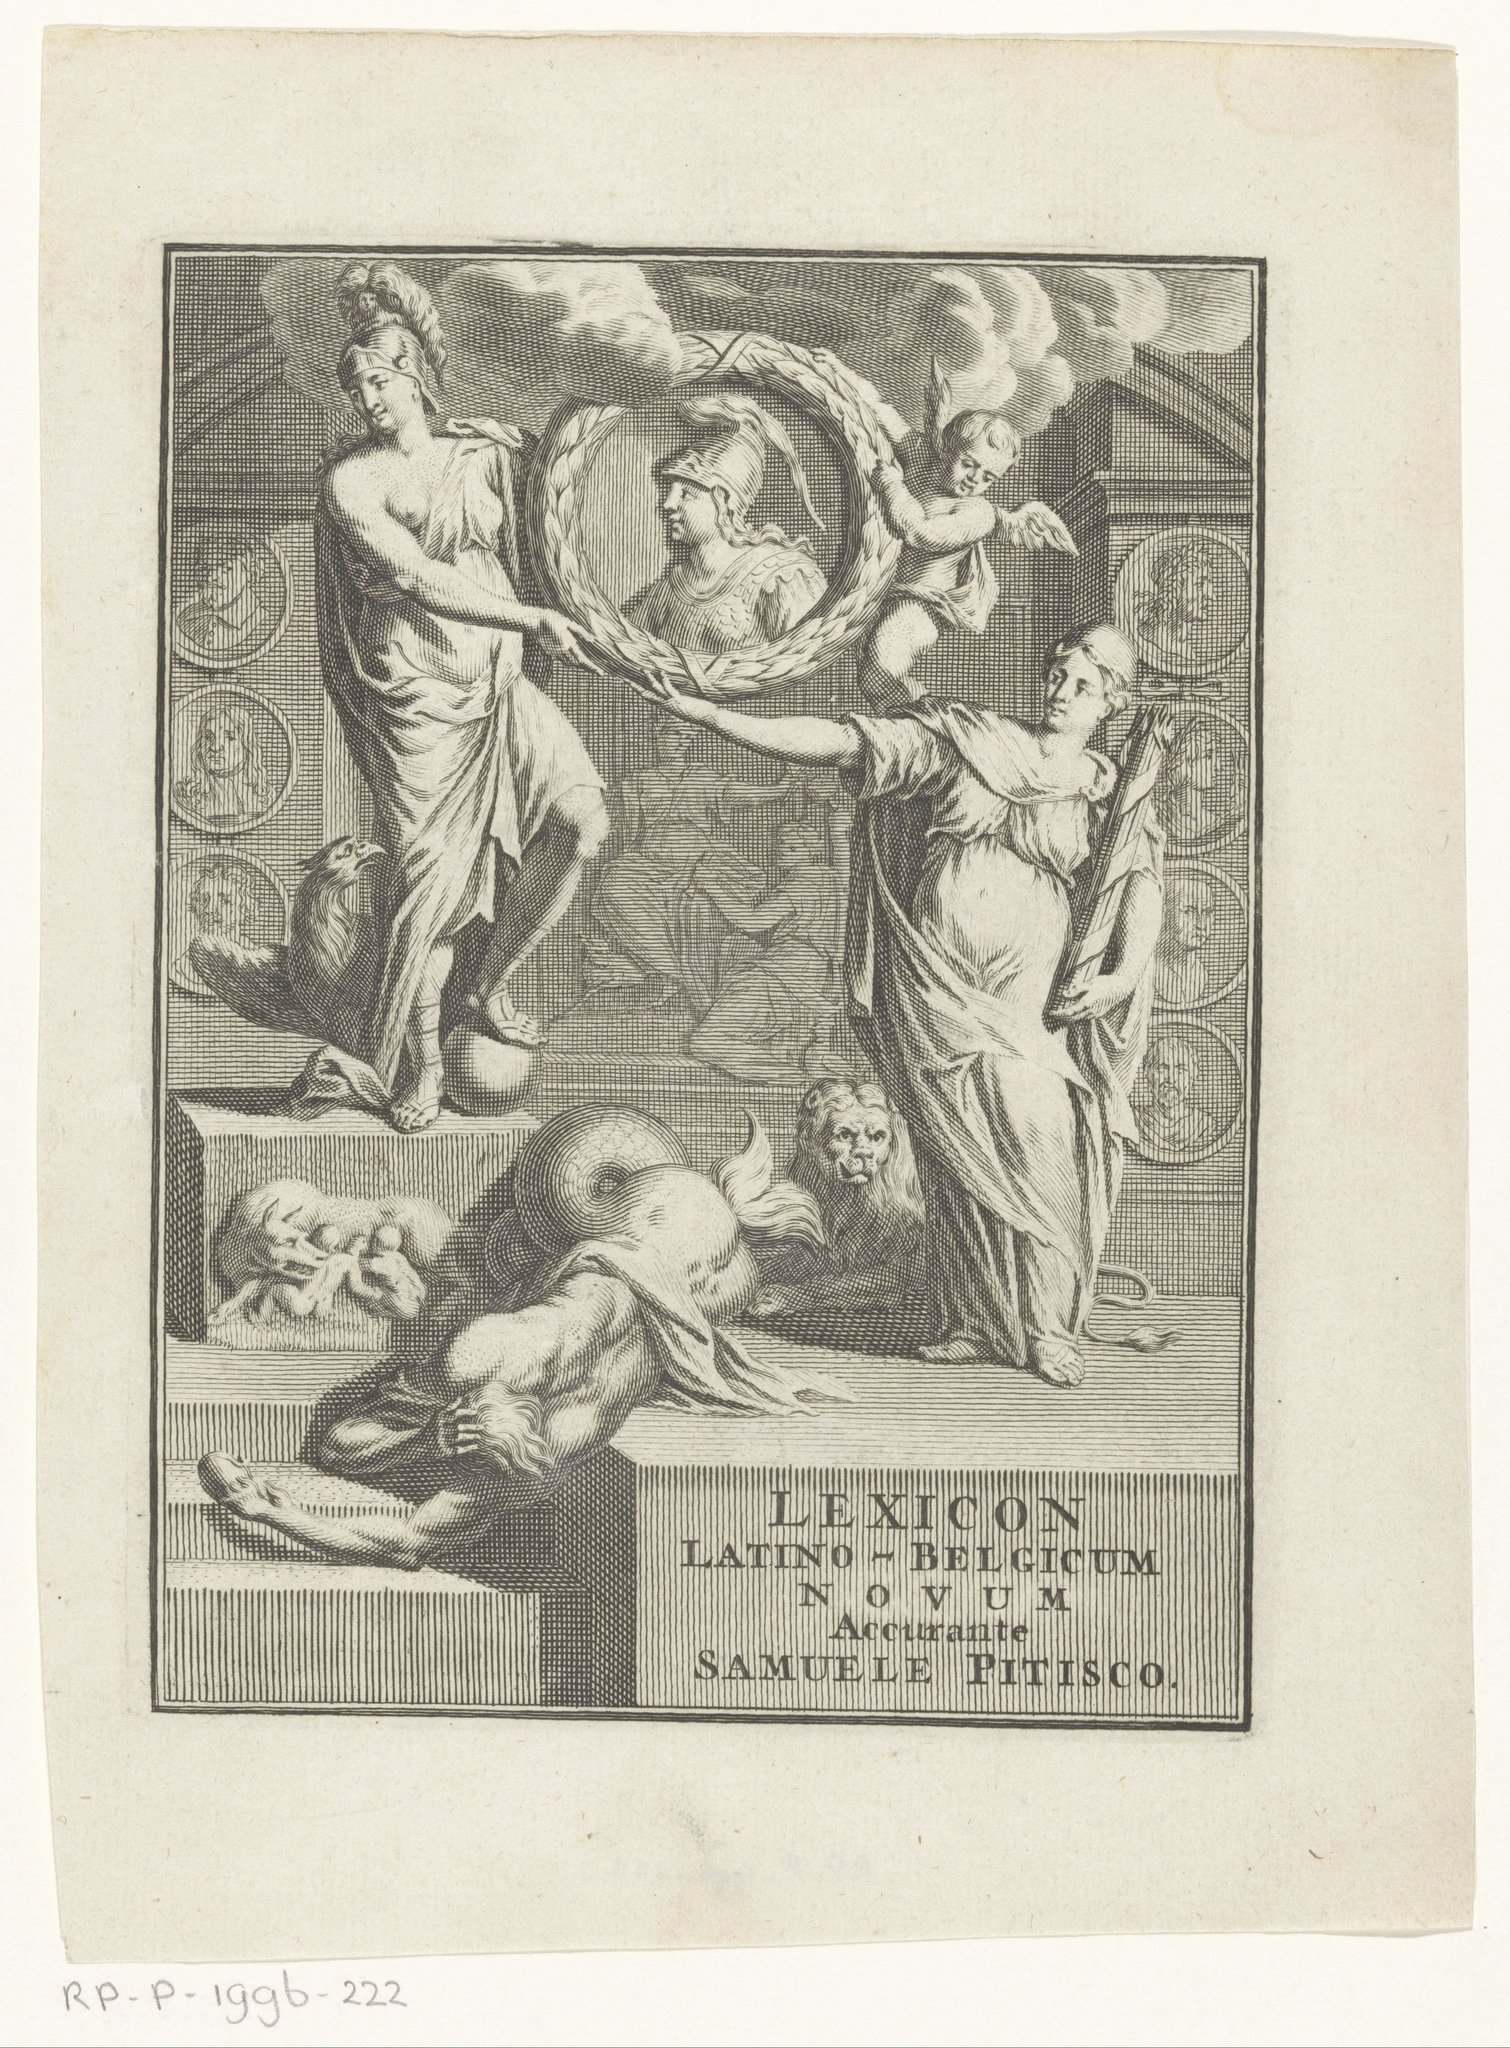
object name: titelblad, titelpagina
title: Allegorische voorstelling met personificaties van de Nederlanden en het Romeinse Rijk en portret van Minerva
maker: Anonymous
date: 1725-1754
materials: paper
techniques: engraving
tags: personifications of countries, nations, states, districts, etc., (story of) minerva (pallas, athena), low countries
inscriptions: collector's mark: Lugt 2760, collector's mark: Lugt 2228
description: De personificatie van de Nederlanden met pijlenbundel en een leeuw en de personificatie van het Romeinse Rijk met een adelaar, een globe en de afbeelding van de wolvin met Romulus en Remus, houden een portret van Minerva in lauwerkrans omhoog. Een meerman valt neer bij hun voeten. Op de muur achter hen portretten in medaillons van figuren uit de oudheid en eigen tijd.